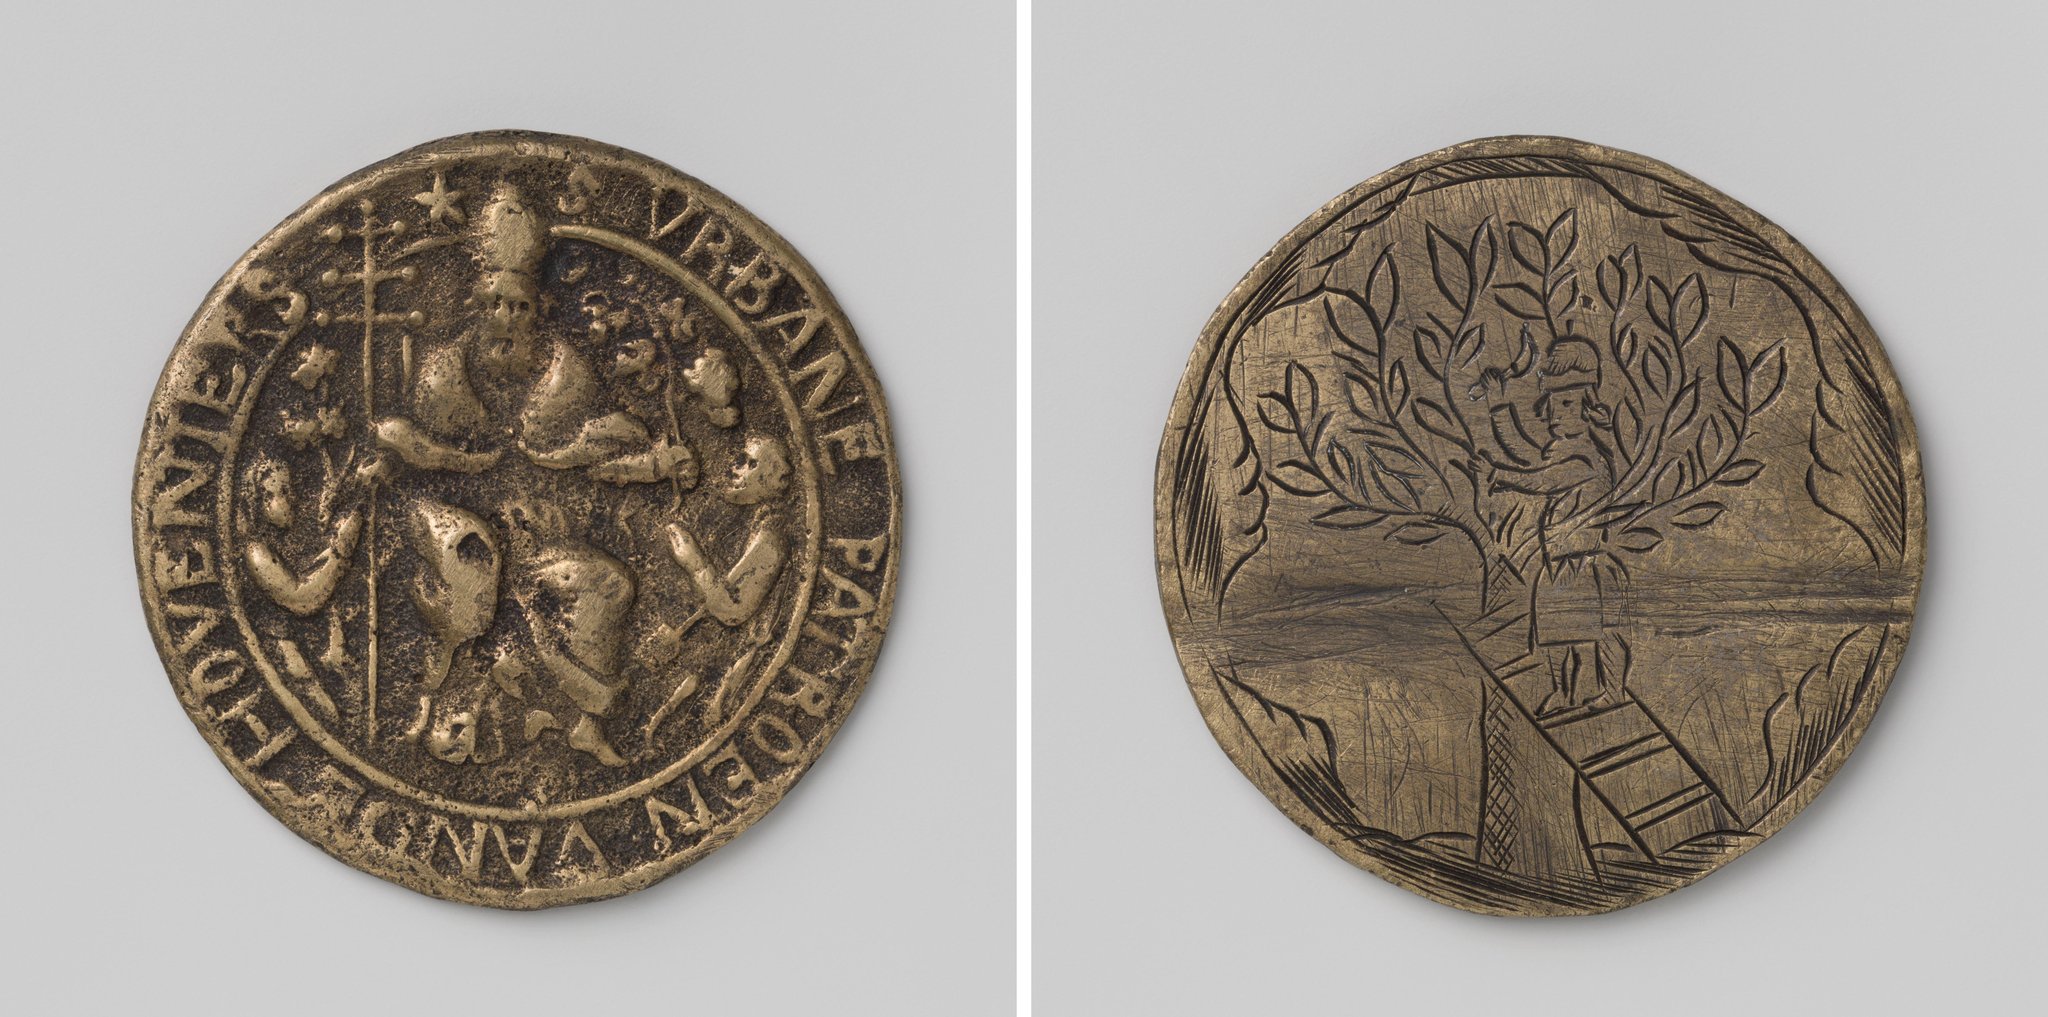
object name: medal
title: Hoveniersgilde van Maastricht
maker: Anonymous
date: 1706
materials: brass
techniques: casting, engraving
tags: maastricht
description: Messing penning. Voorzijde: St. Urbanus met mijter op hoofd houdt patriarchaal kruis in rechter- en wijnrank in linkerhand; links: een hovenier met een boompje, rechts een hovenier met een spade binnen omschrift. Keerzijde: hovenier staande op tegen boom leunende ladder